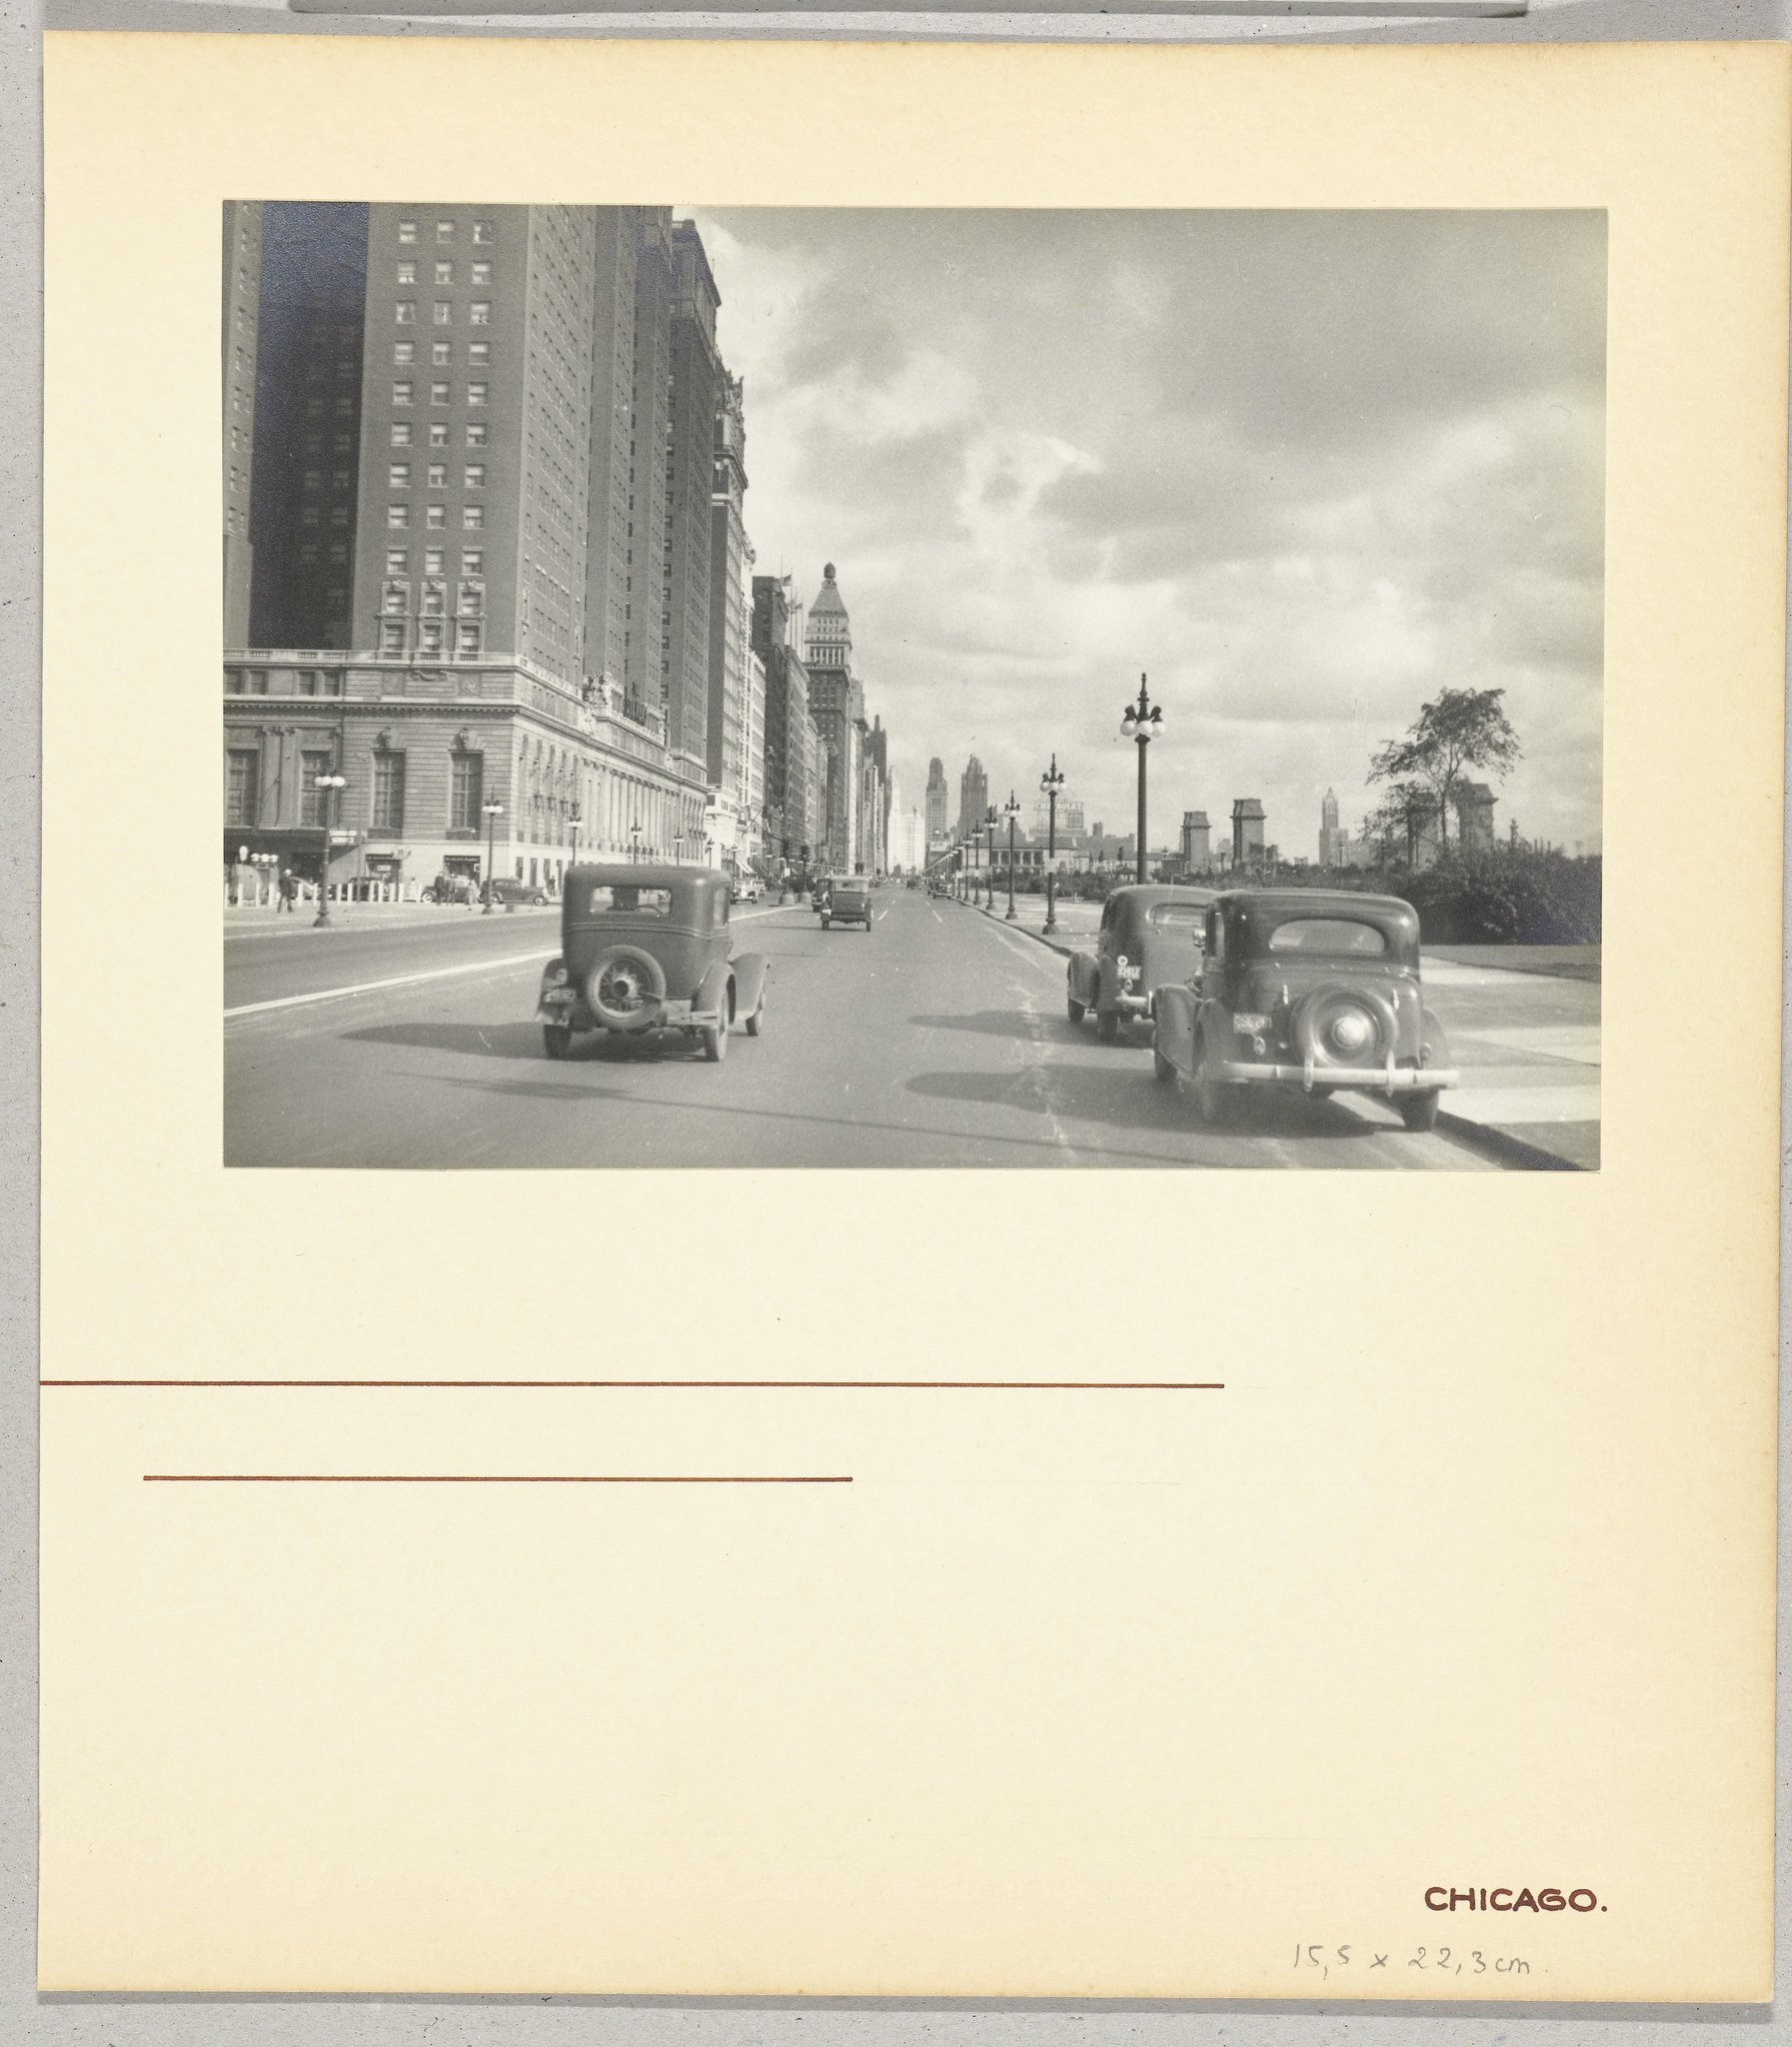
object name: photograph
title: Gezicht in Chicago, Verenigde Staten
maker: wouter cool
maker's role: engineer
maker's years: 1877-1947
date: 1936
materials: cardboard, paper, photographic support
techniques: gelatin silver print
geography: united states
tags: city-view, and landscape with man-made constructions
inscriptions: title: ‘CHICAGO.’